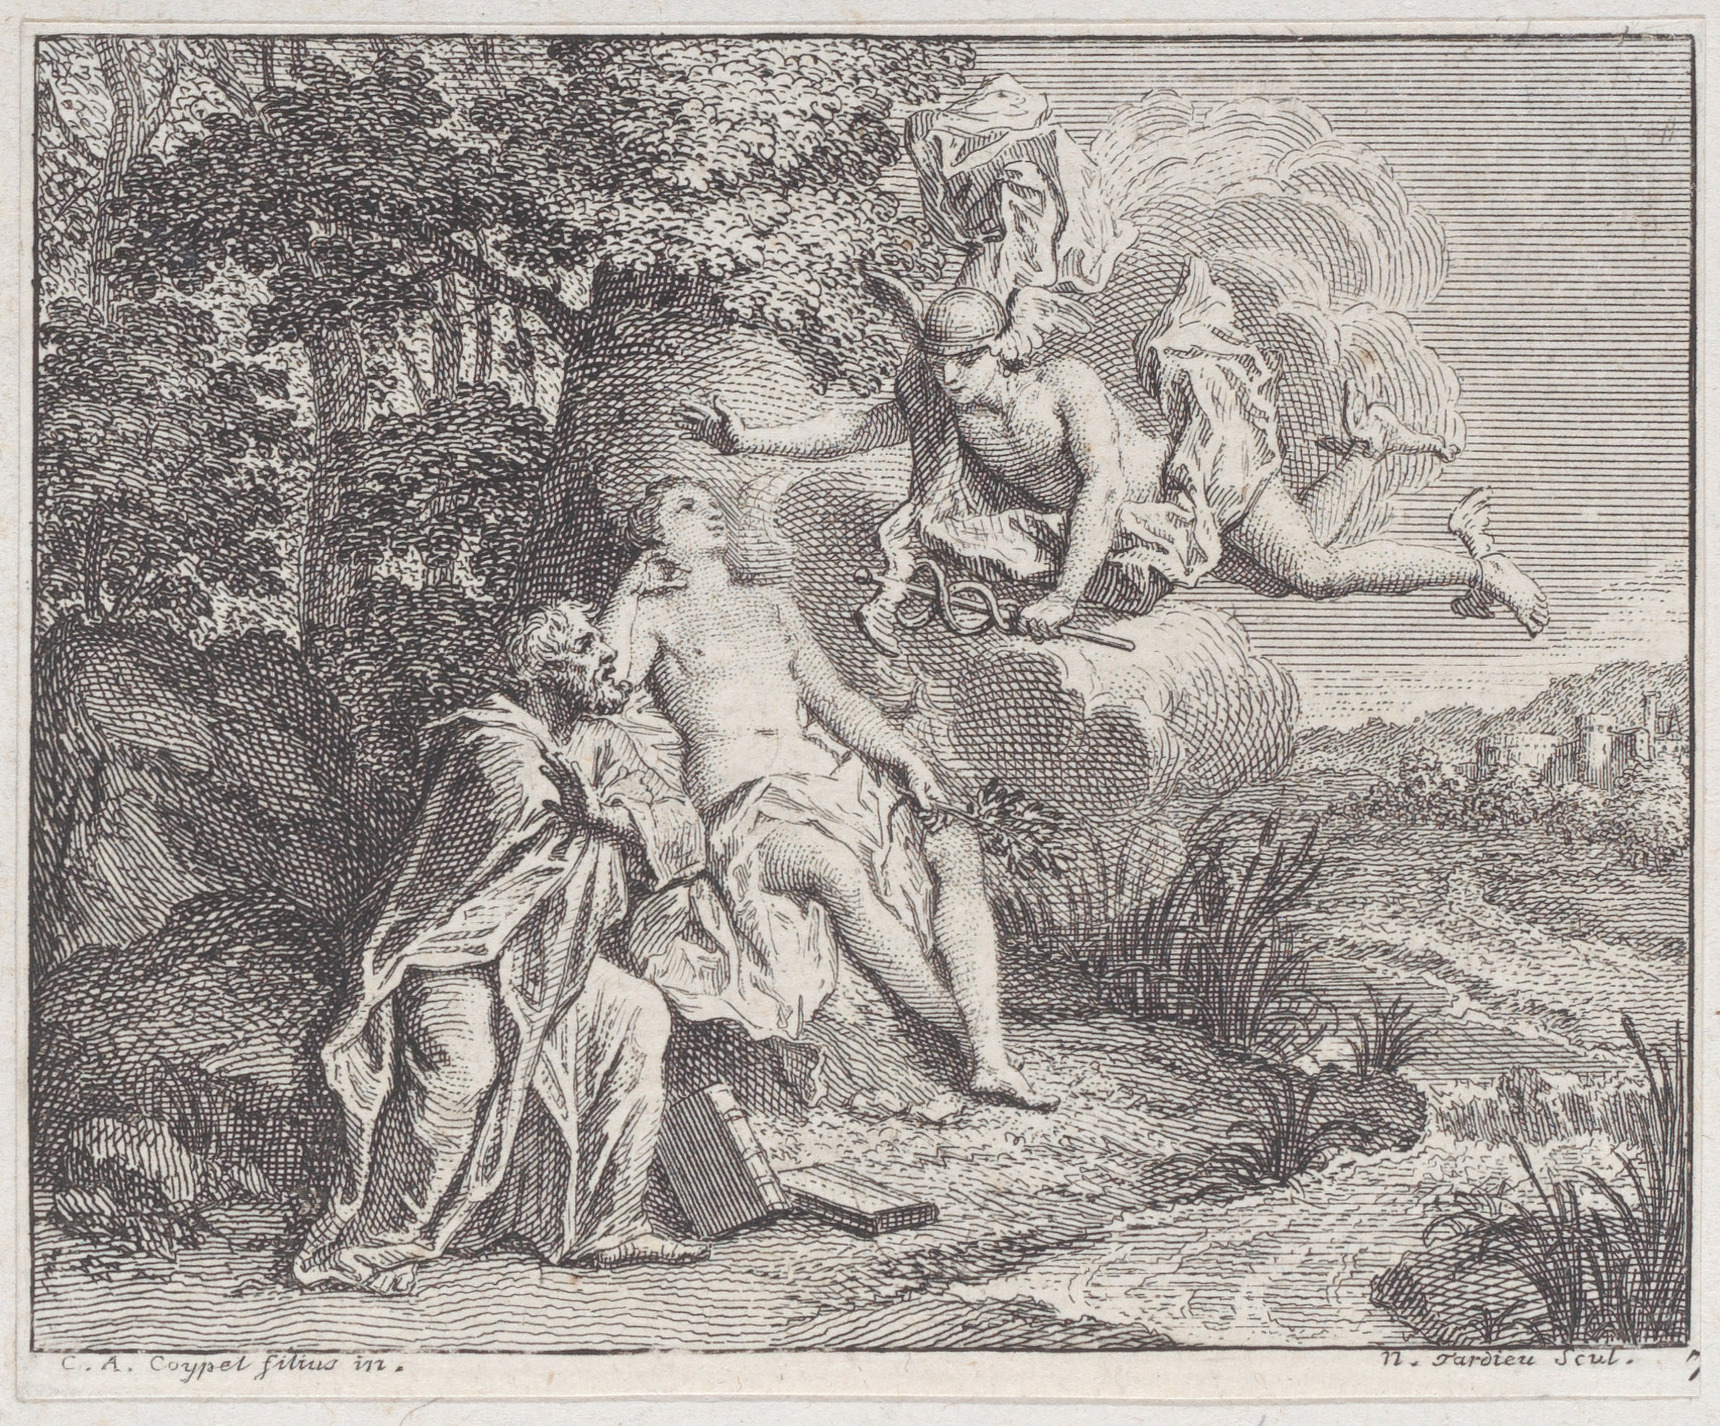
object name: print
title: Book 4, Fable 16: The Peace (La Paix), from "Fables Nouvelles"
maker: nicolas henry tardieu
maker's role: artist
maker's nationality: french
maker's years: 1674-1749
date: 1719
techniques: engraving, etching